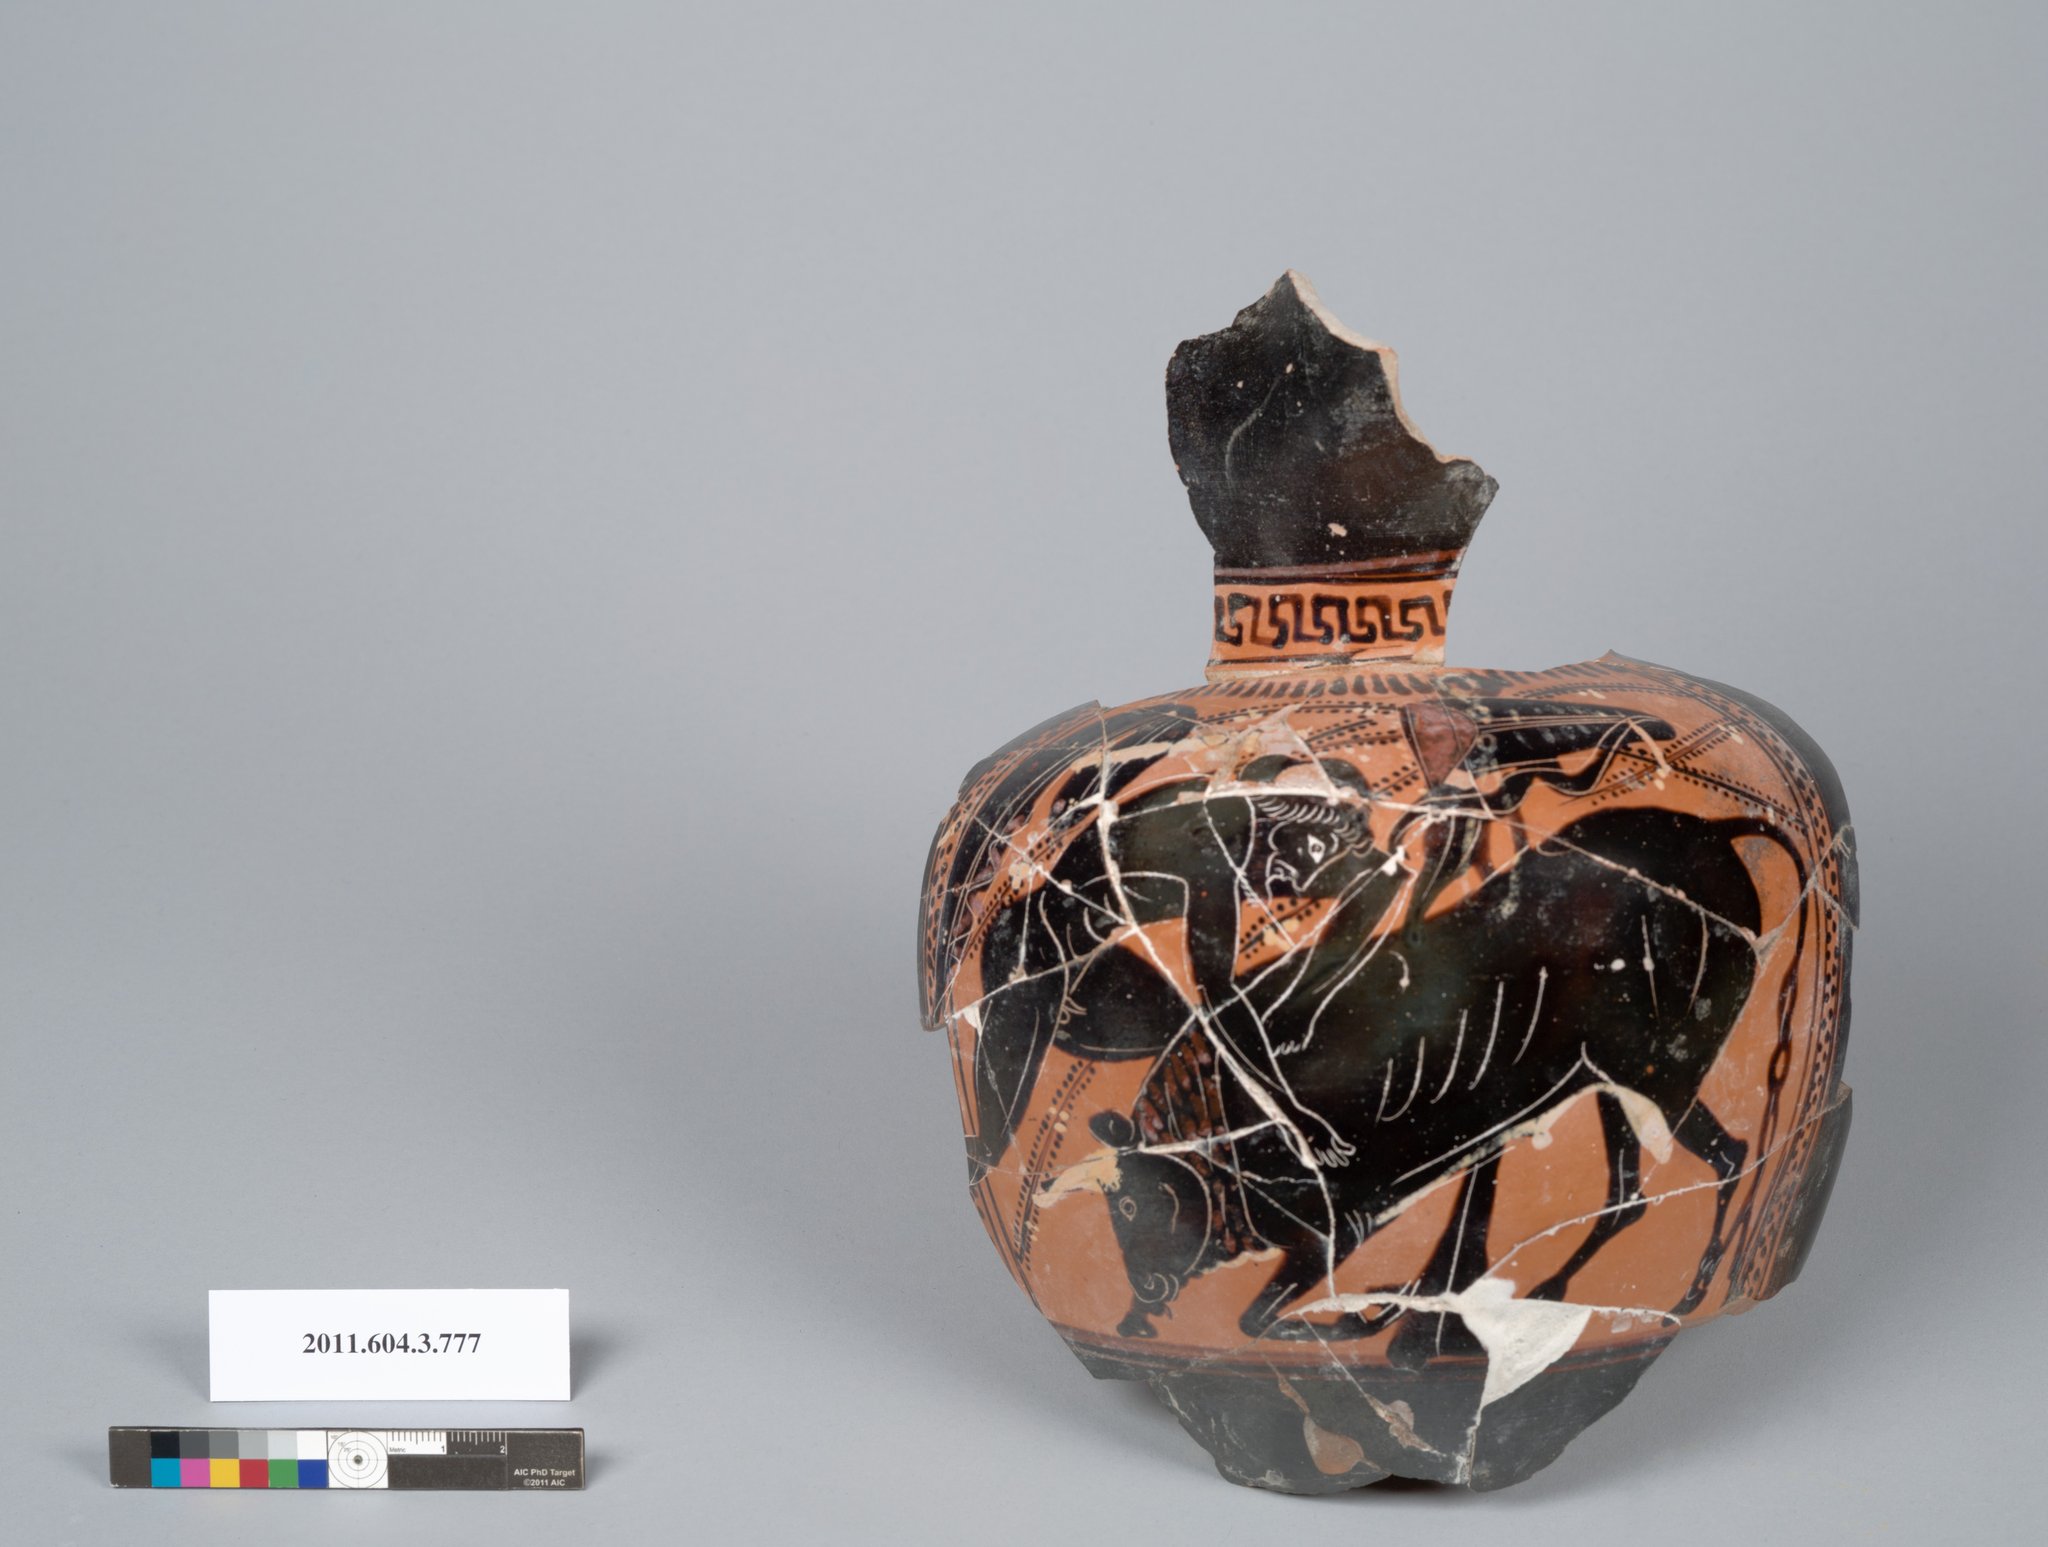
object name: oinochoe fragment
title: Terracotta fragment of an oinochoe (jug)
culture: greek, attic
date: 534-468 BCE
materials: terracotta